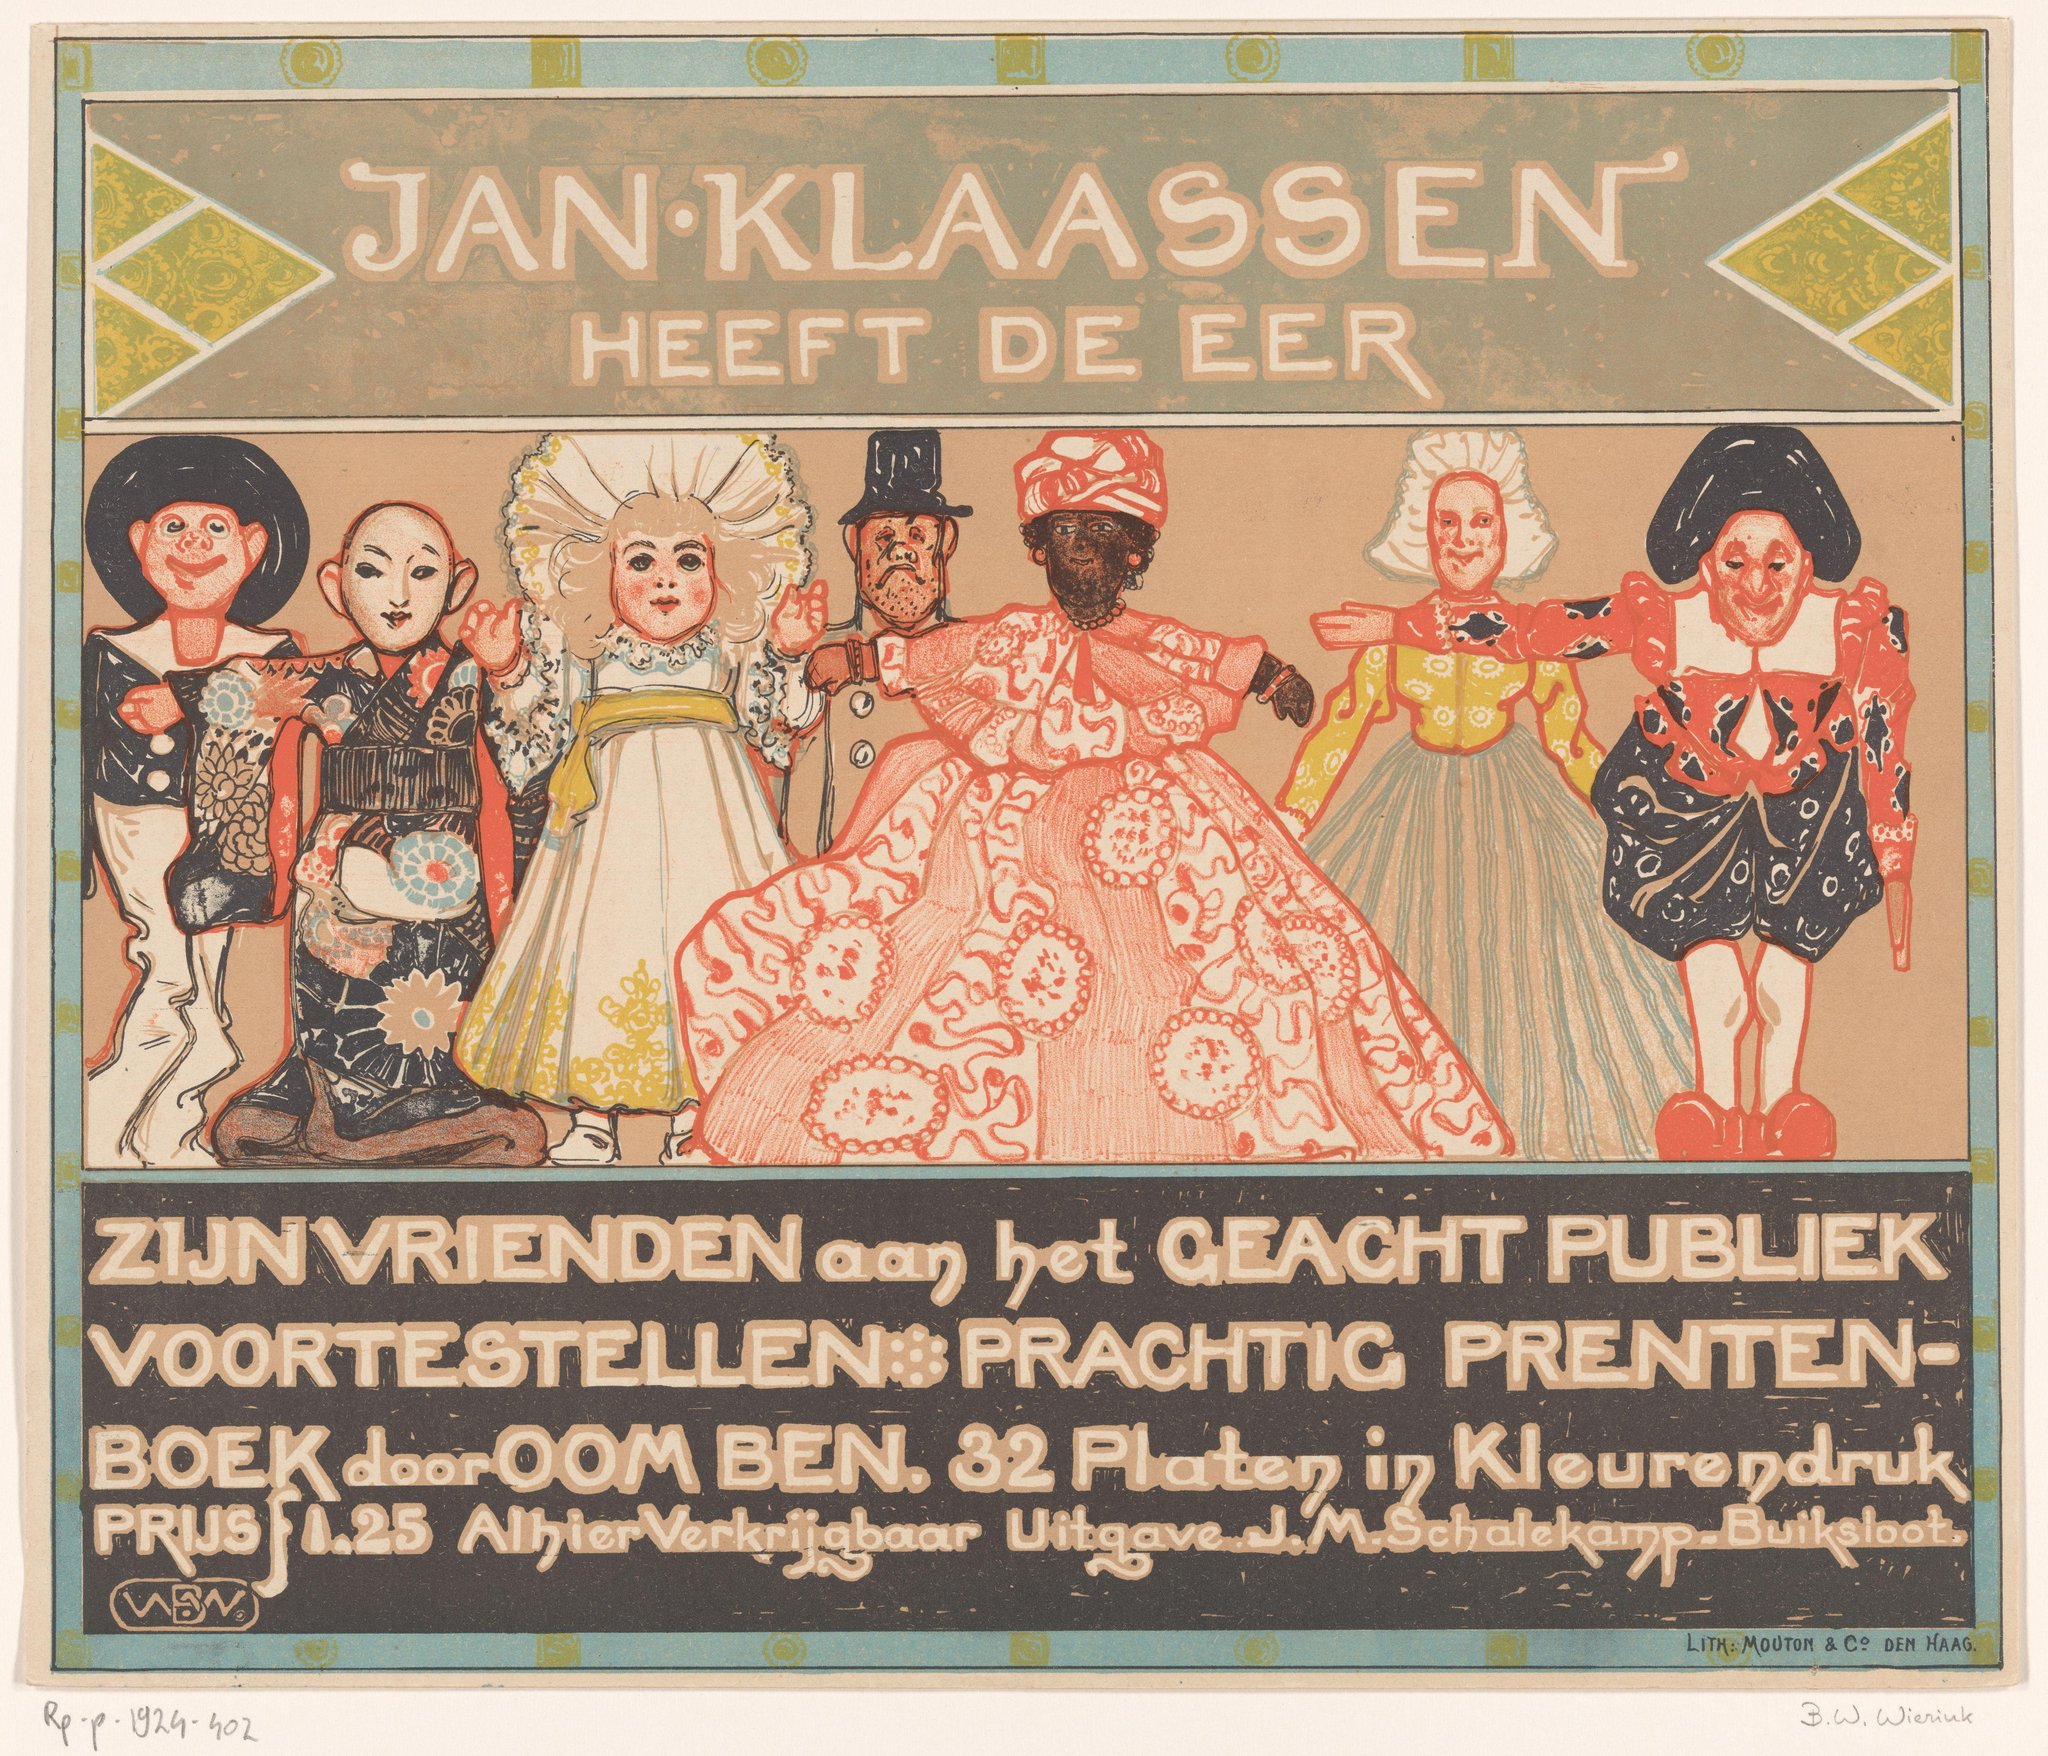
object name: print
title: Jan Klaassen heeft de eer zijn vrienden aan het geacht publiek voortestellen (...)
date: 1903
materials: paper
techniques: lithograph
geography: amsterdam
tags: book in which illustrations are essential, puppet and marionette show